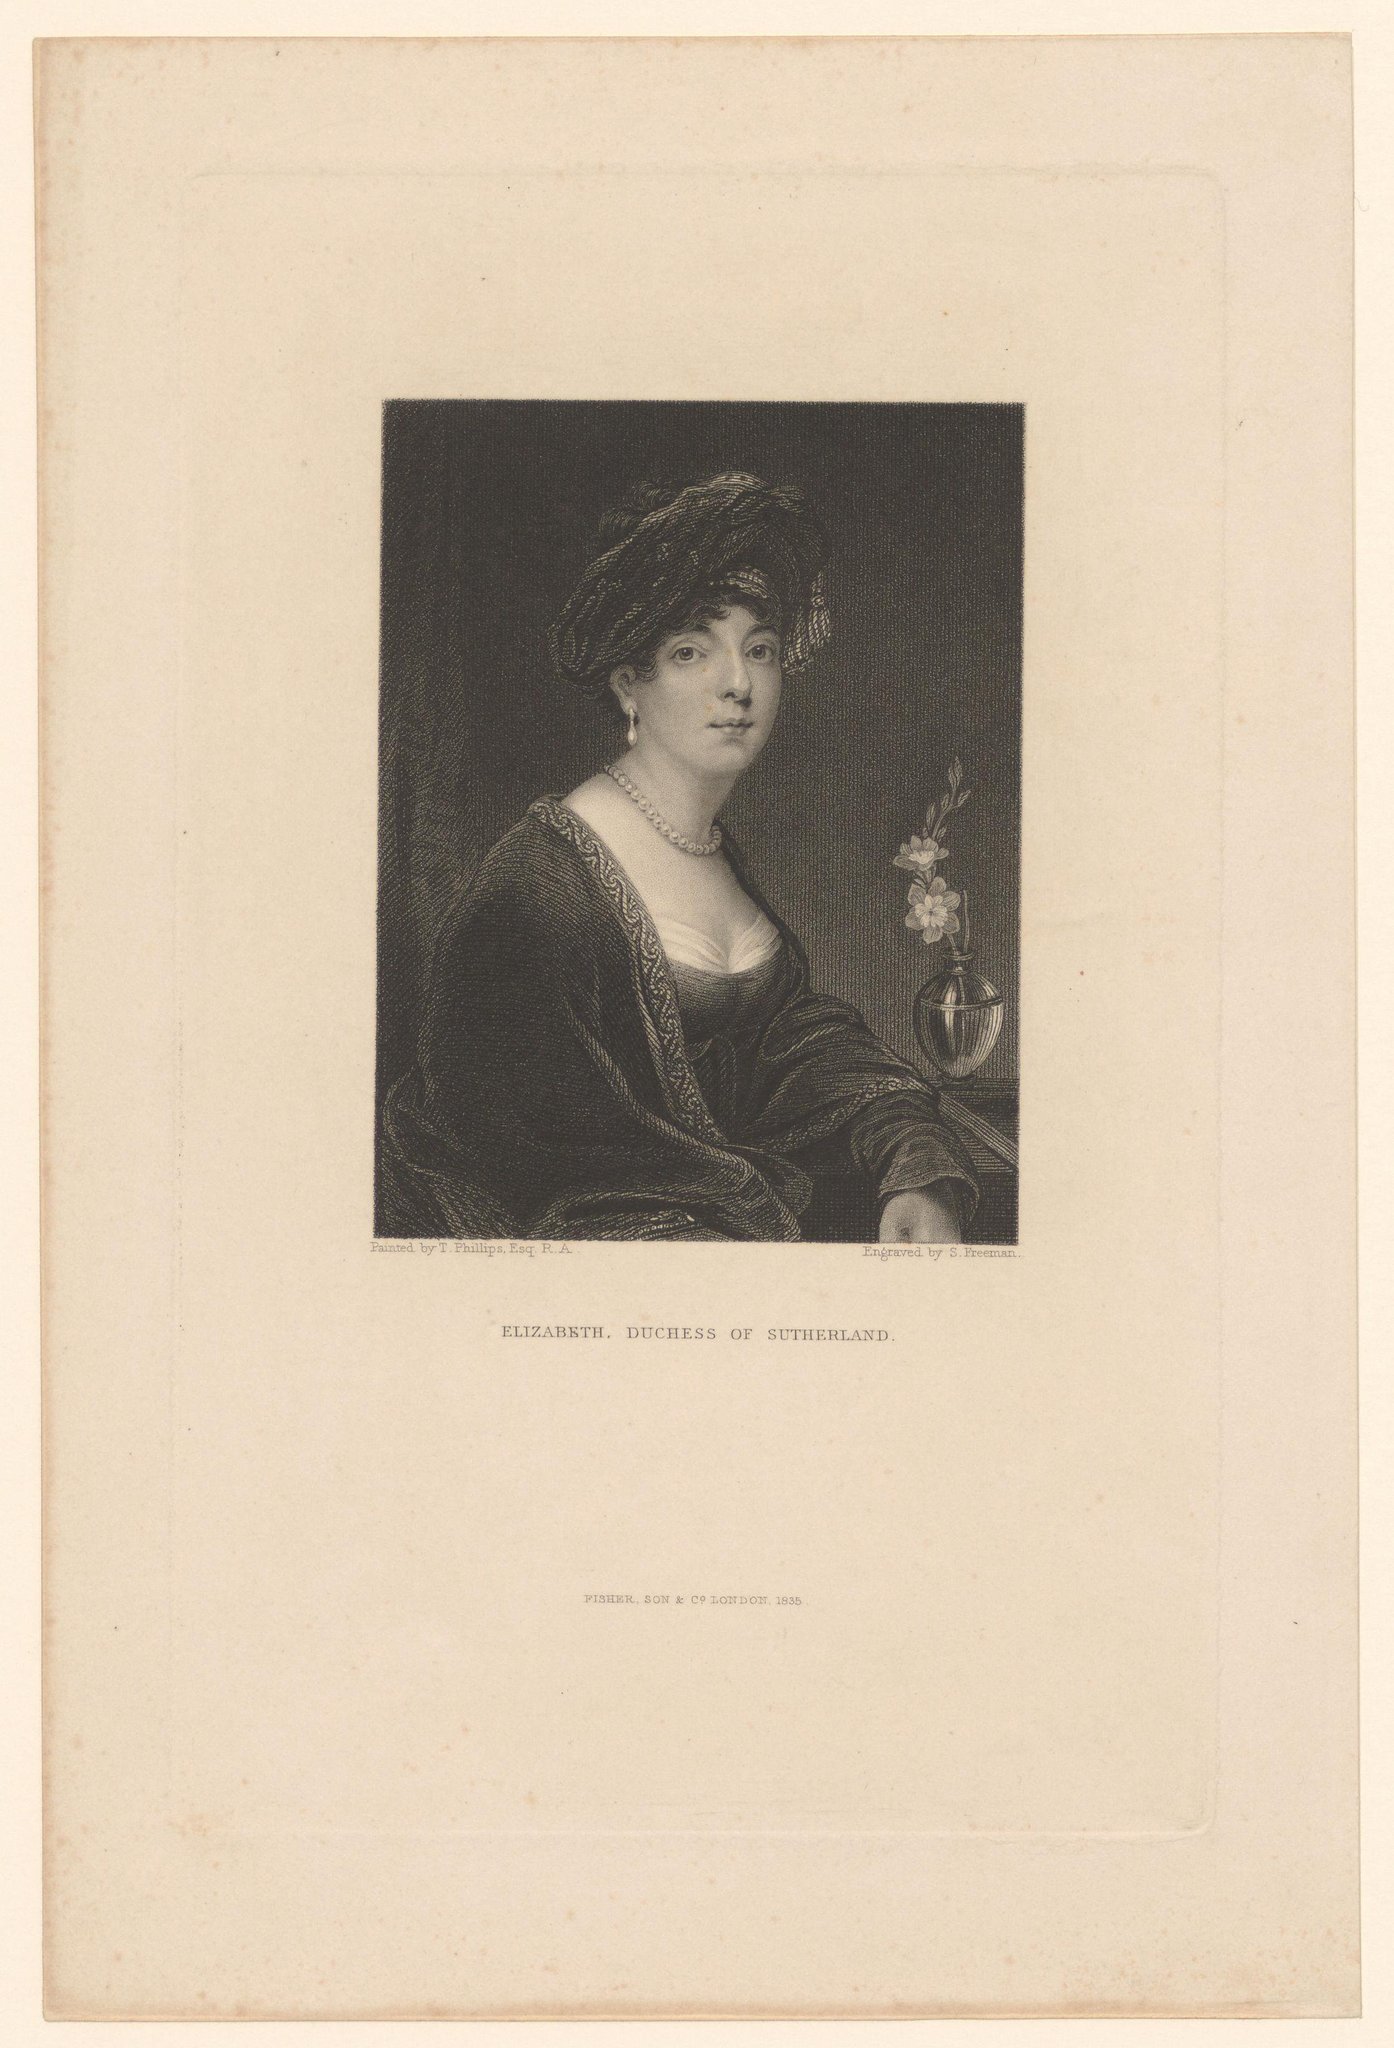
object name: print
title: Portret van Elizabeth van Sutherland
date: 1835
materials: paper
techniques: etching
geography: london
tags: historical persons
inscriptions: collector's mark: Lugt 2228